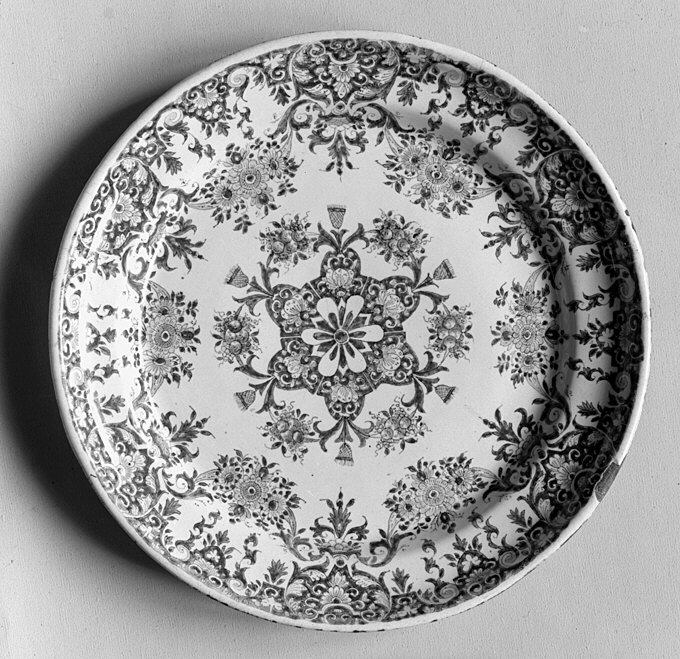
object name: plate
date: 1720-1730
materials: faience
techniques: glazing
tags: flowers